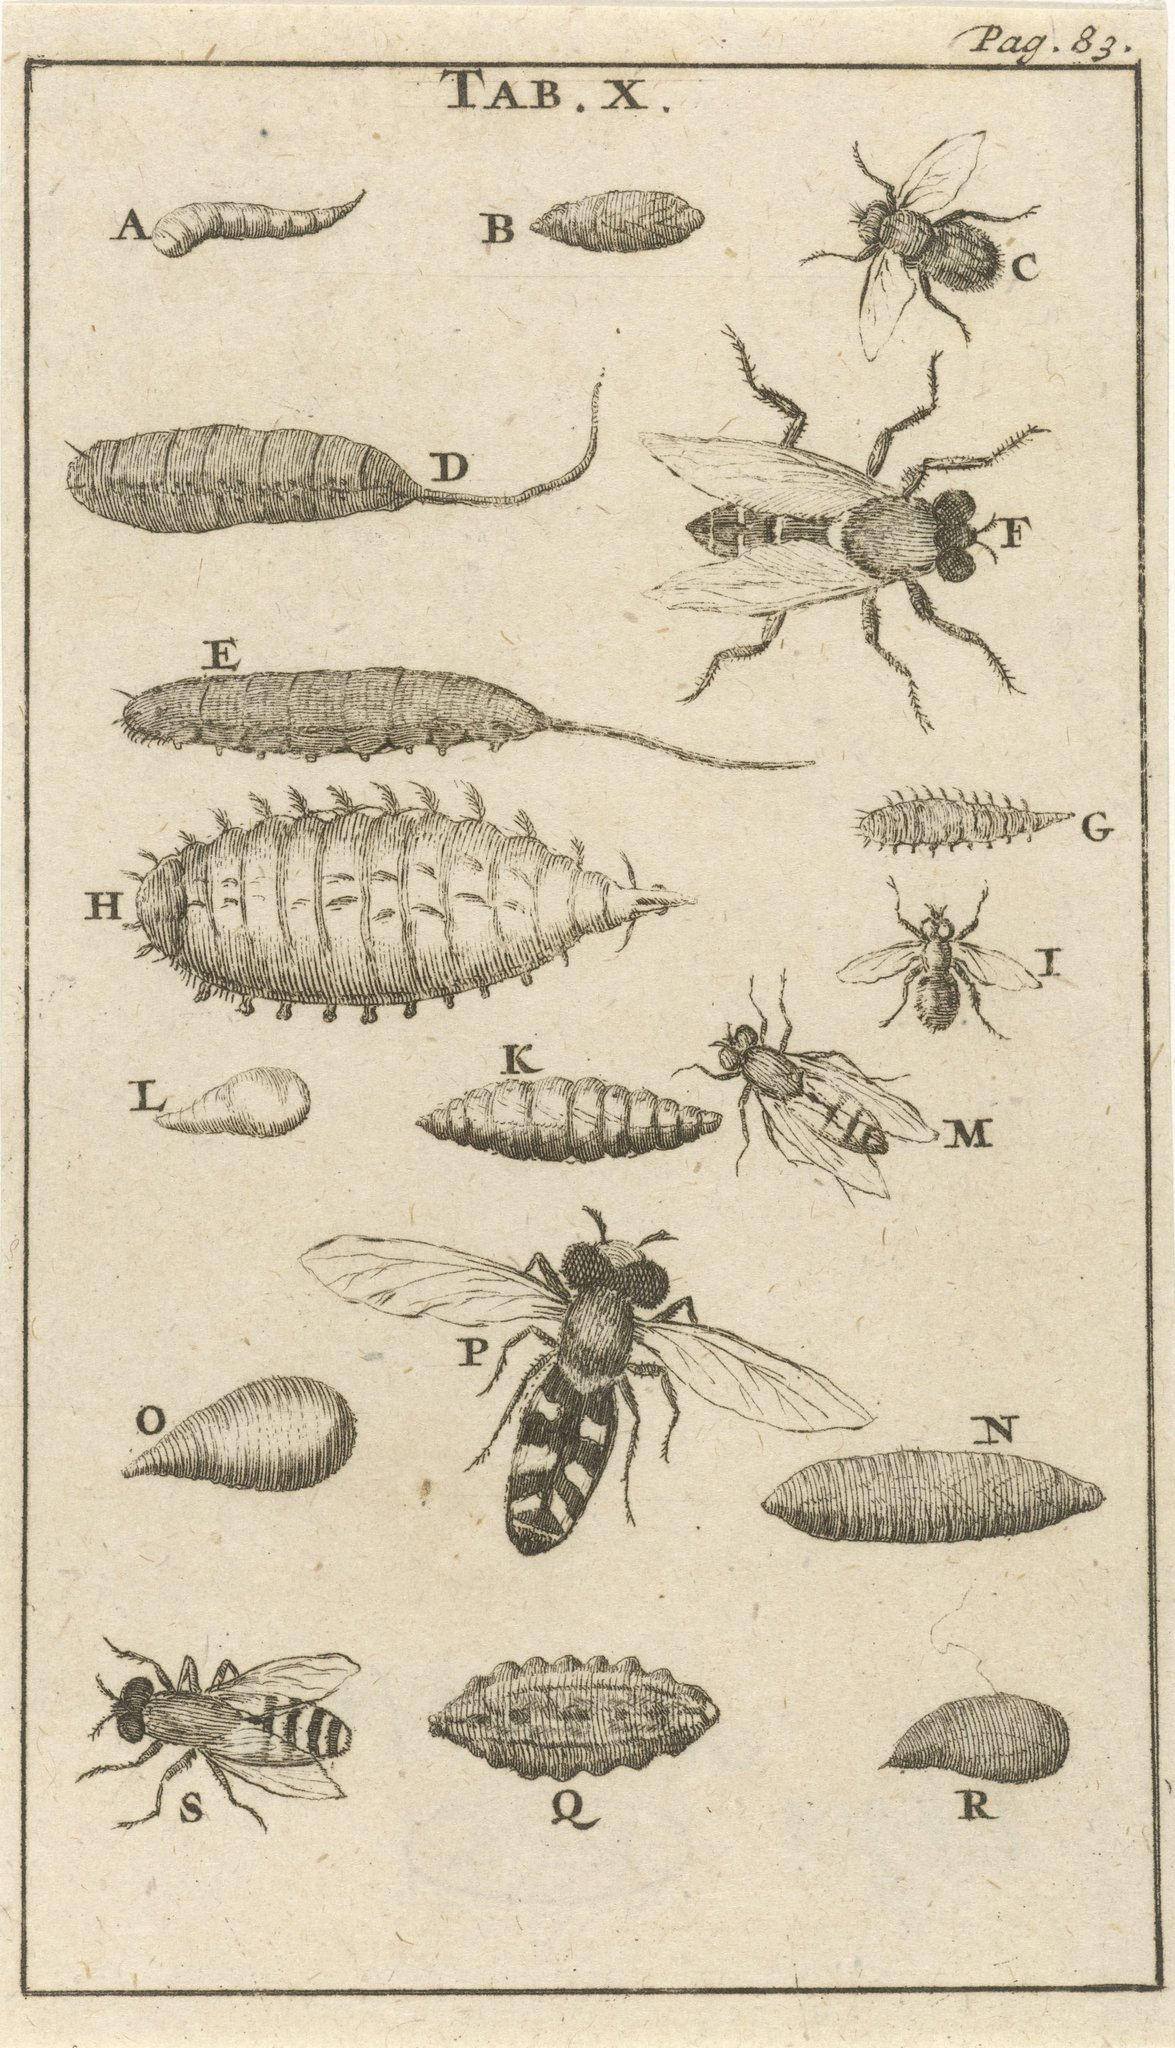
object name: book illustration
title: Bijen en wespen X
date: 1680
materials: paper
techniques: etching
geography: amsterdam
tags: insects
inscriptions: collector's mark: Lugt 2228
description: Illustratie opgenomen in: Blankaart, Steven. Schou-burg der rupsen, wormen, ma'den, en vliegende dierkens daar uit voortkomende. Amsterdam: Jan Claesz ten Hoorn, 1680.